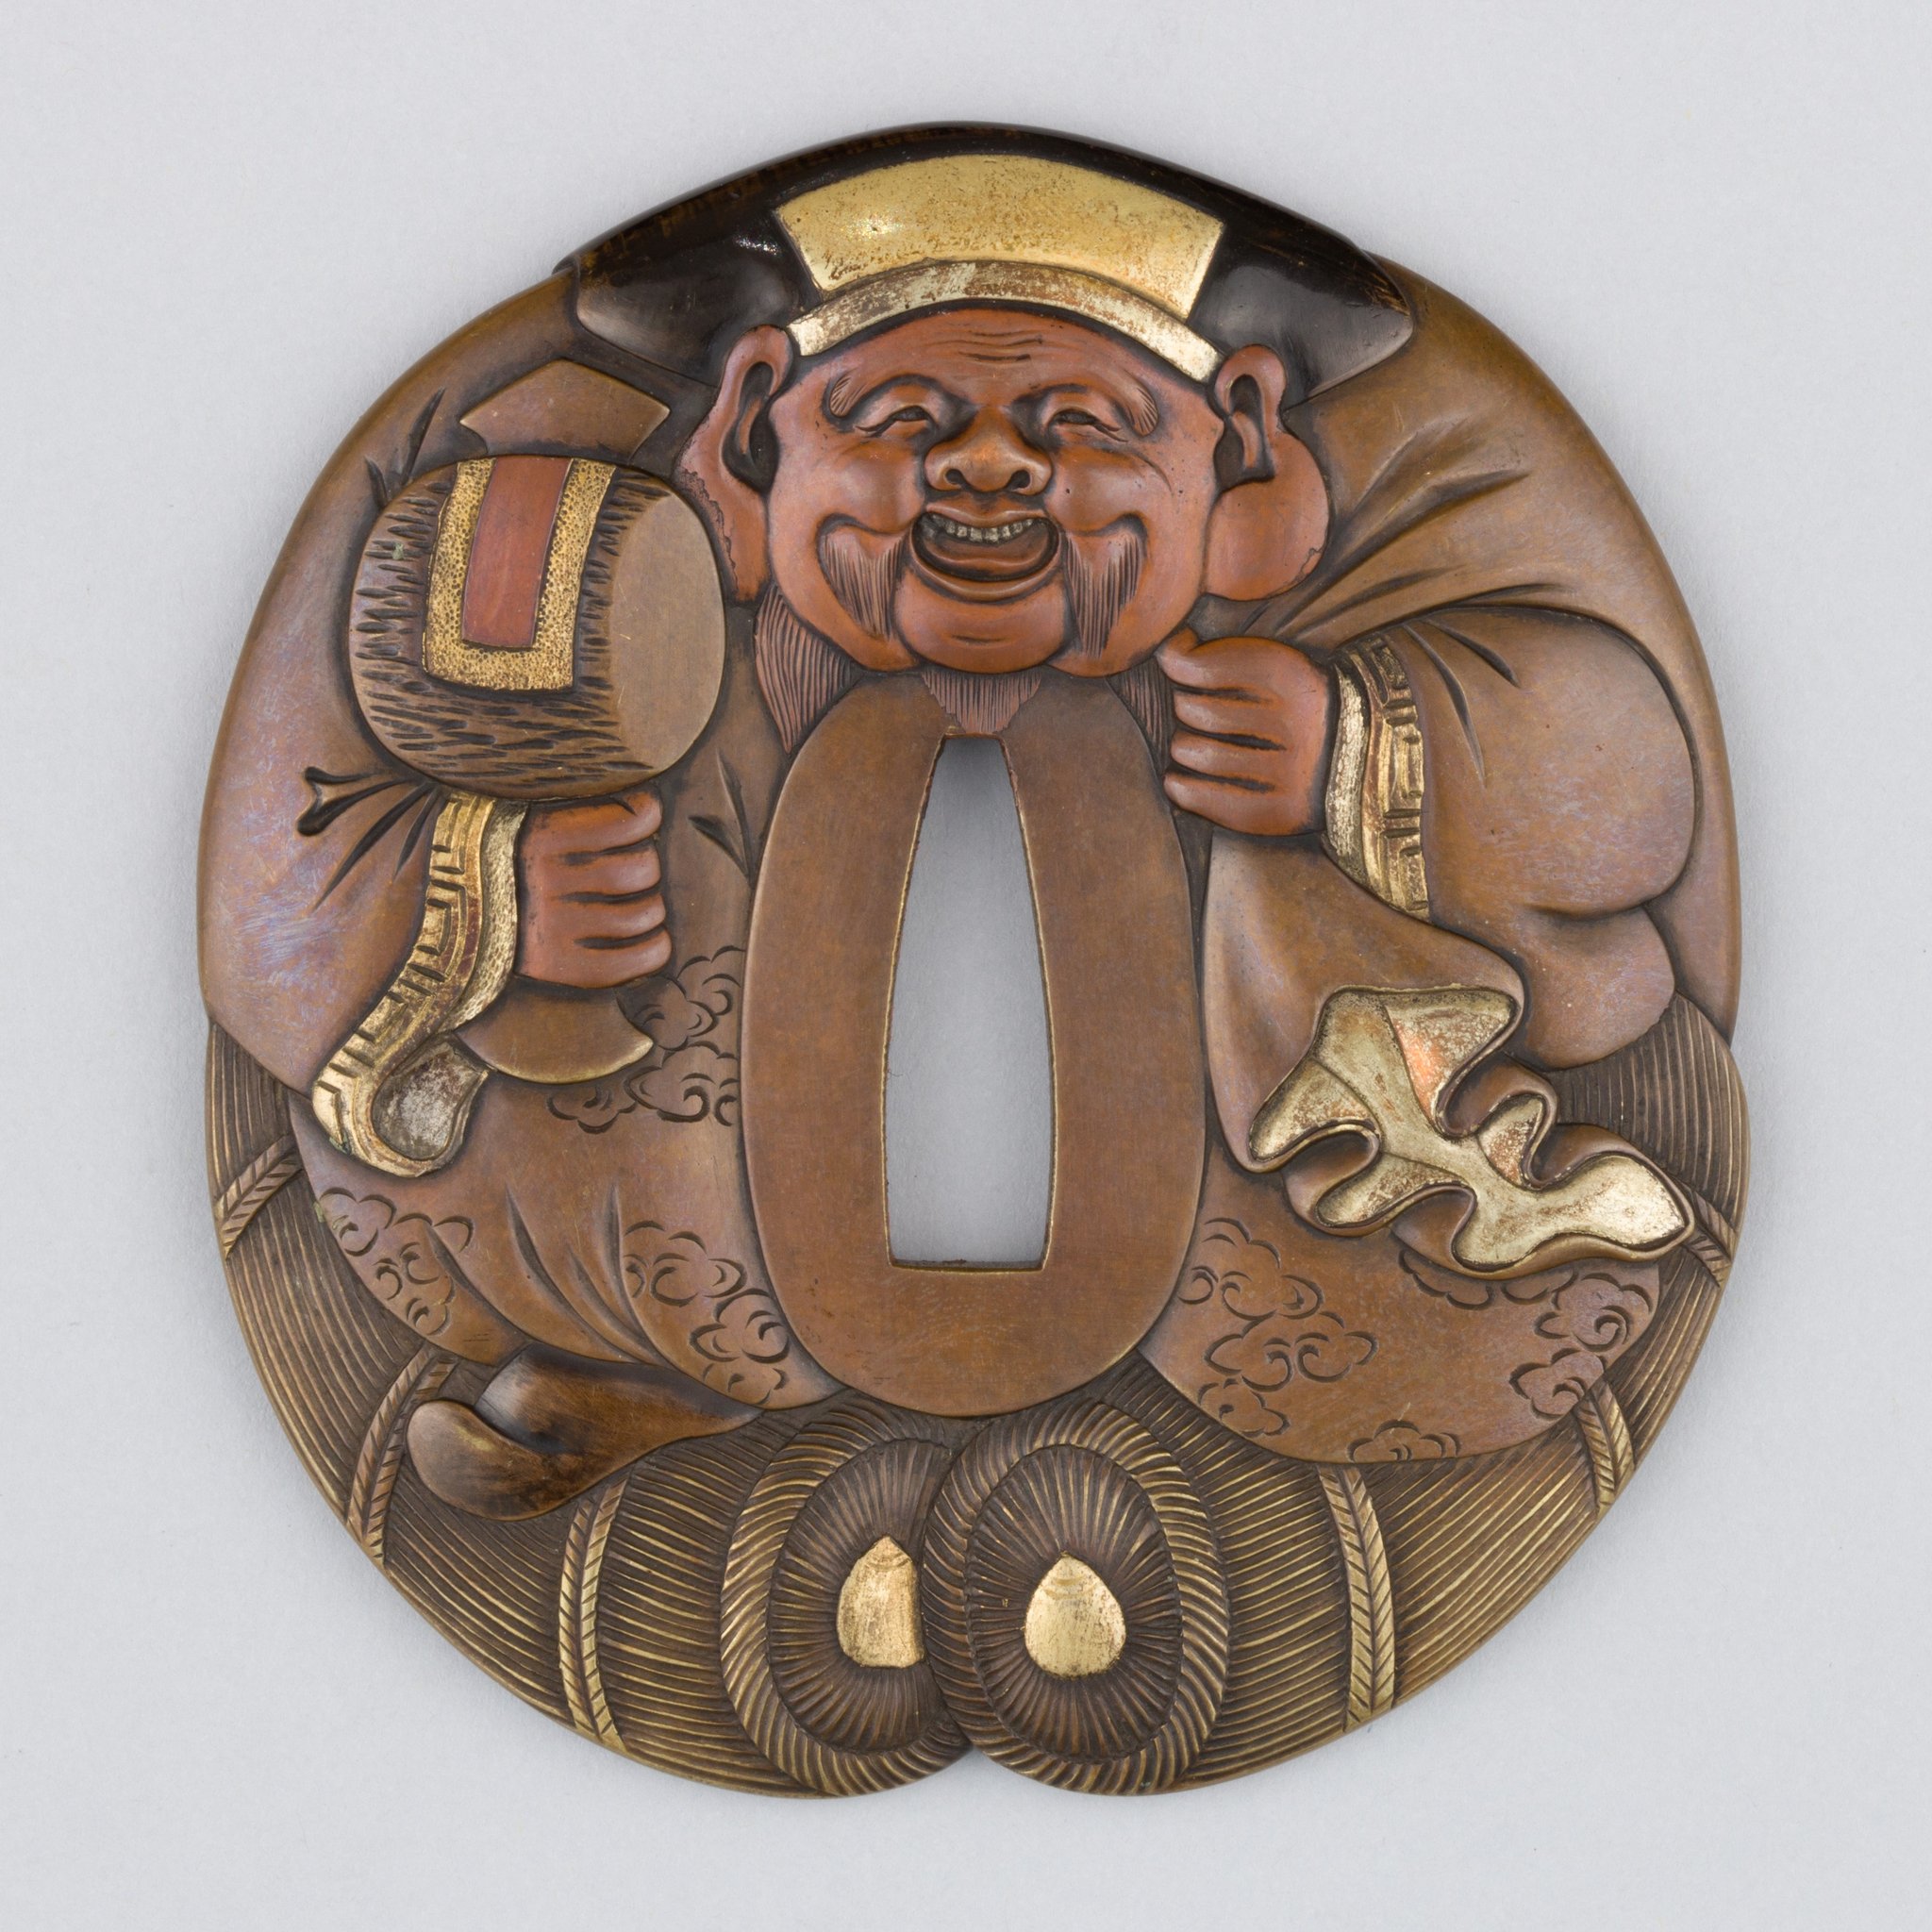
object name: sword guard tsuba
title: Sword Guard (Tsuba)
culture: japanese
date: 1615-1868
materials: copper, copper alloy, gold alloy, gold, silver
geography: japan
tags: men